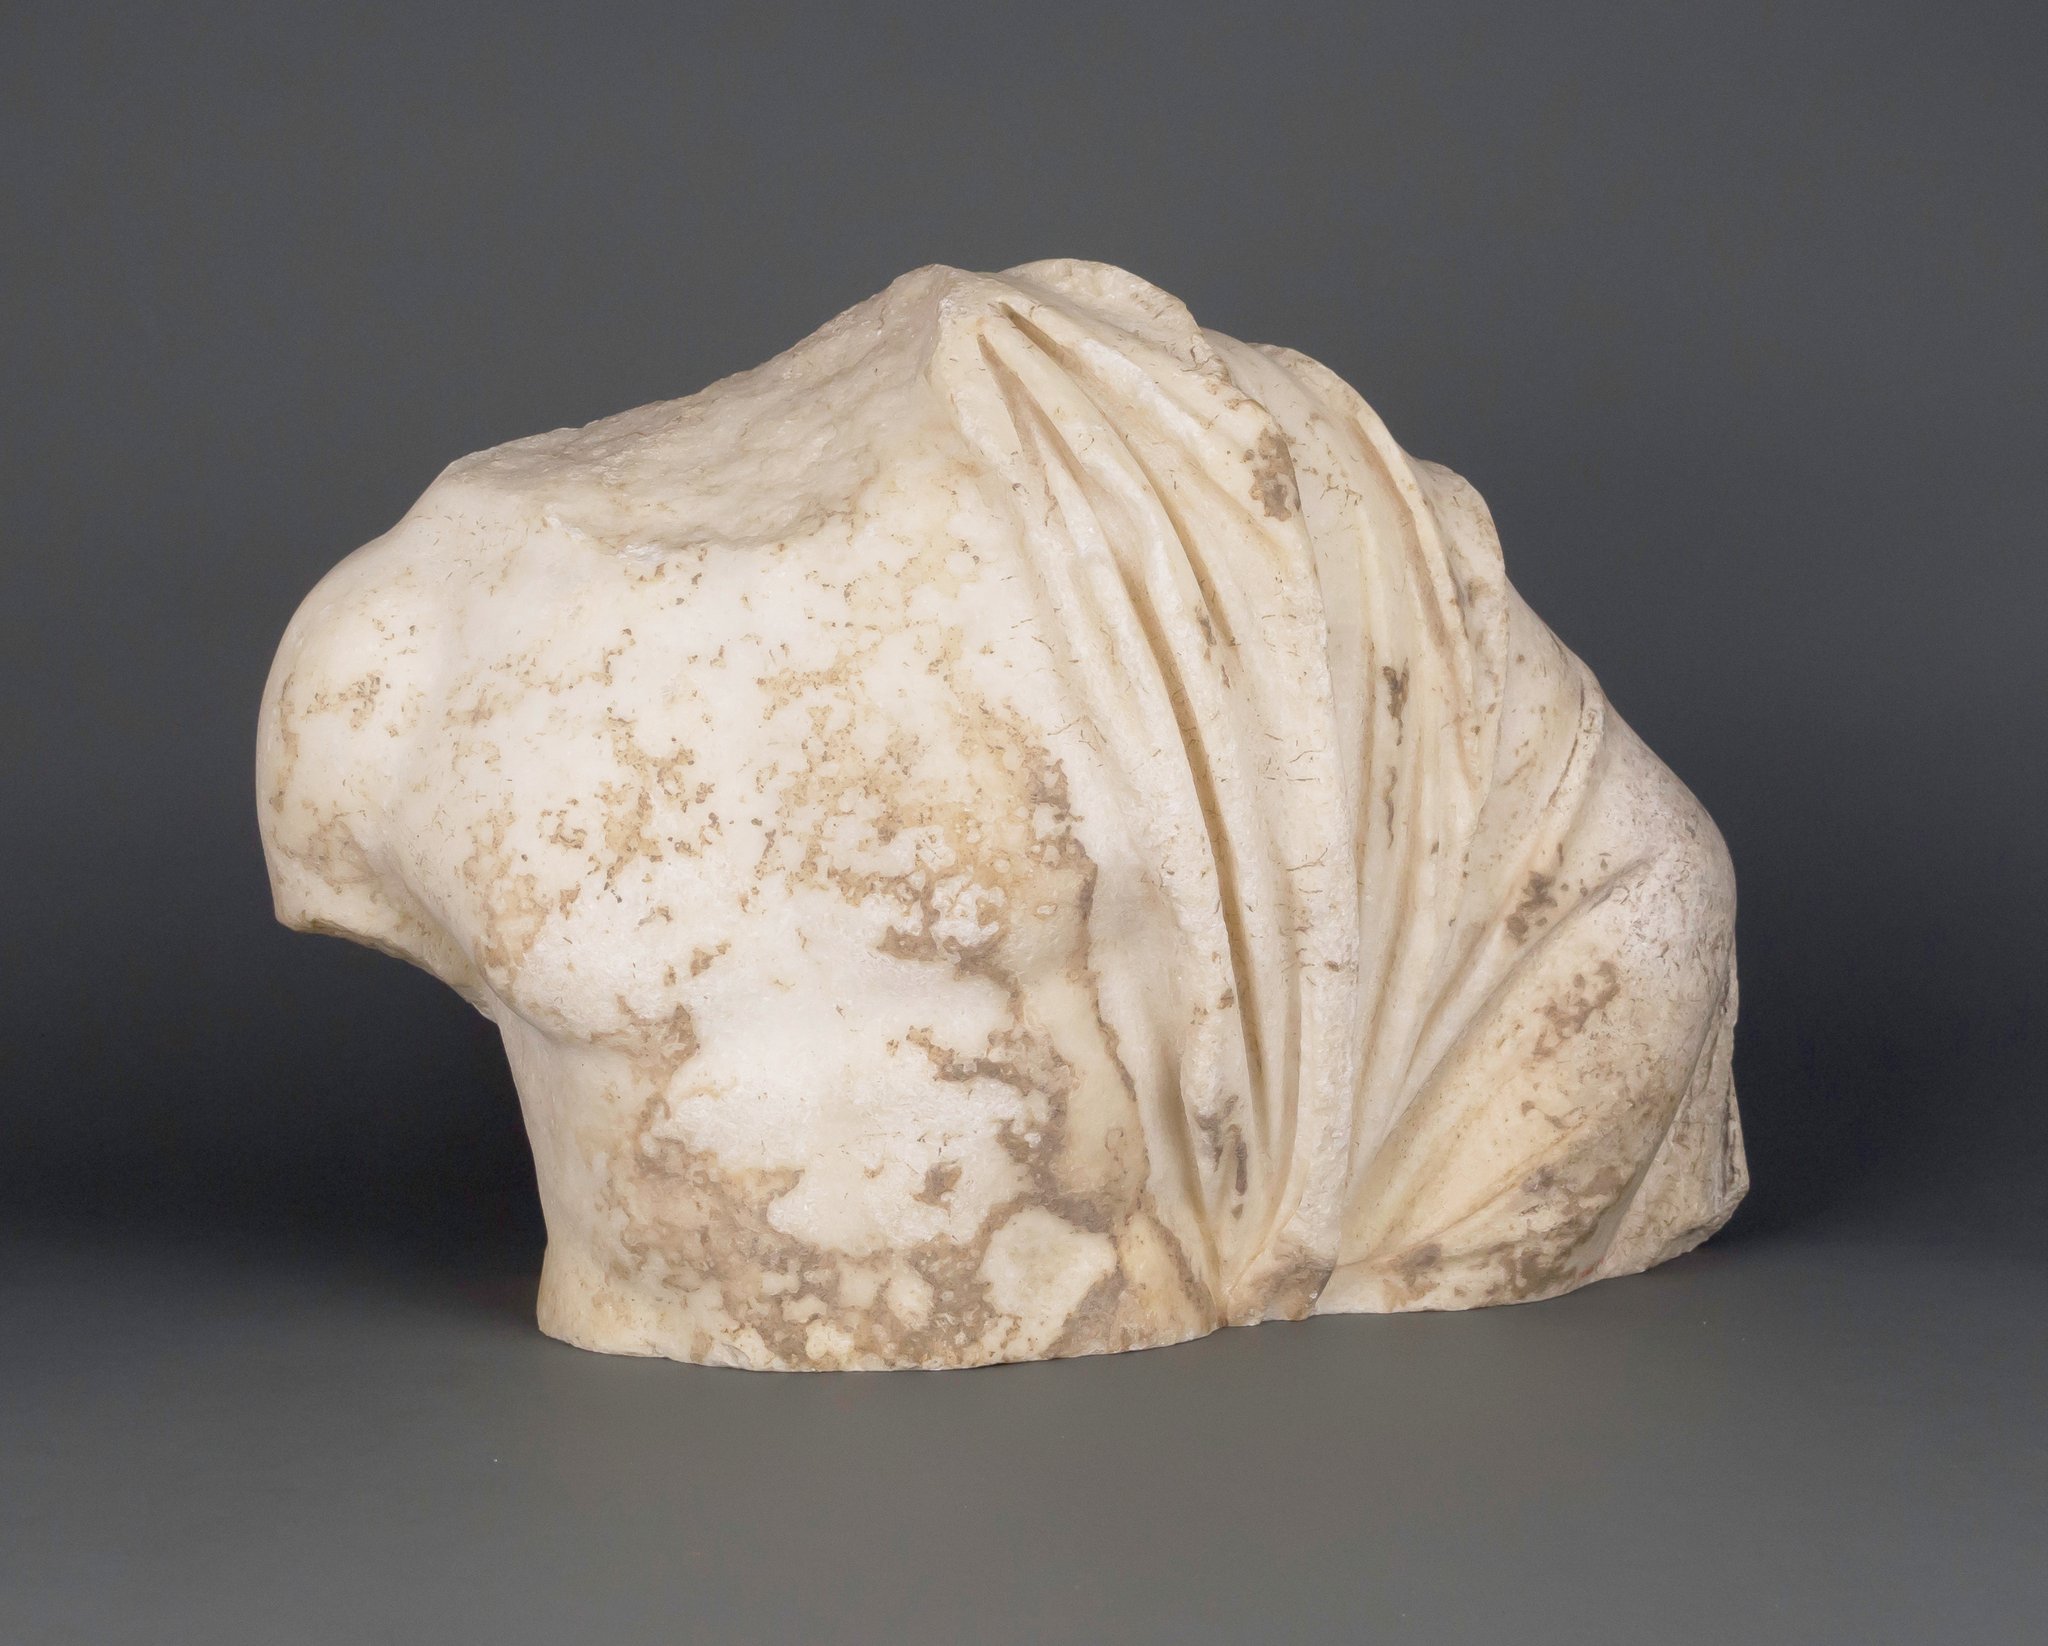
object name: torso of a man, upper part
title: Upper part of a male draped torso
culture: roman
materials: marble